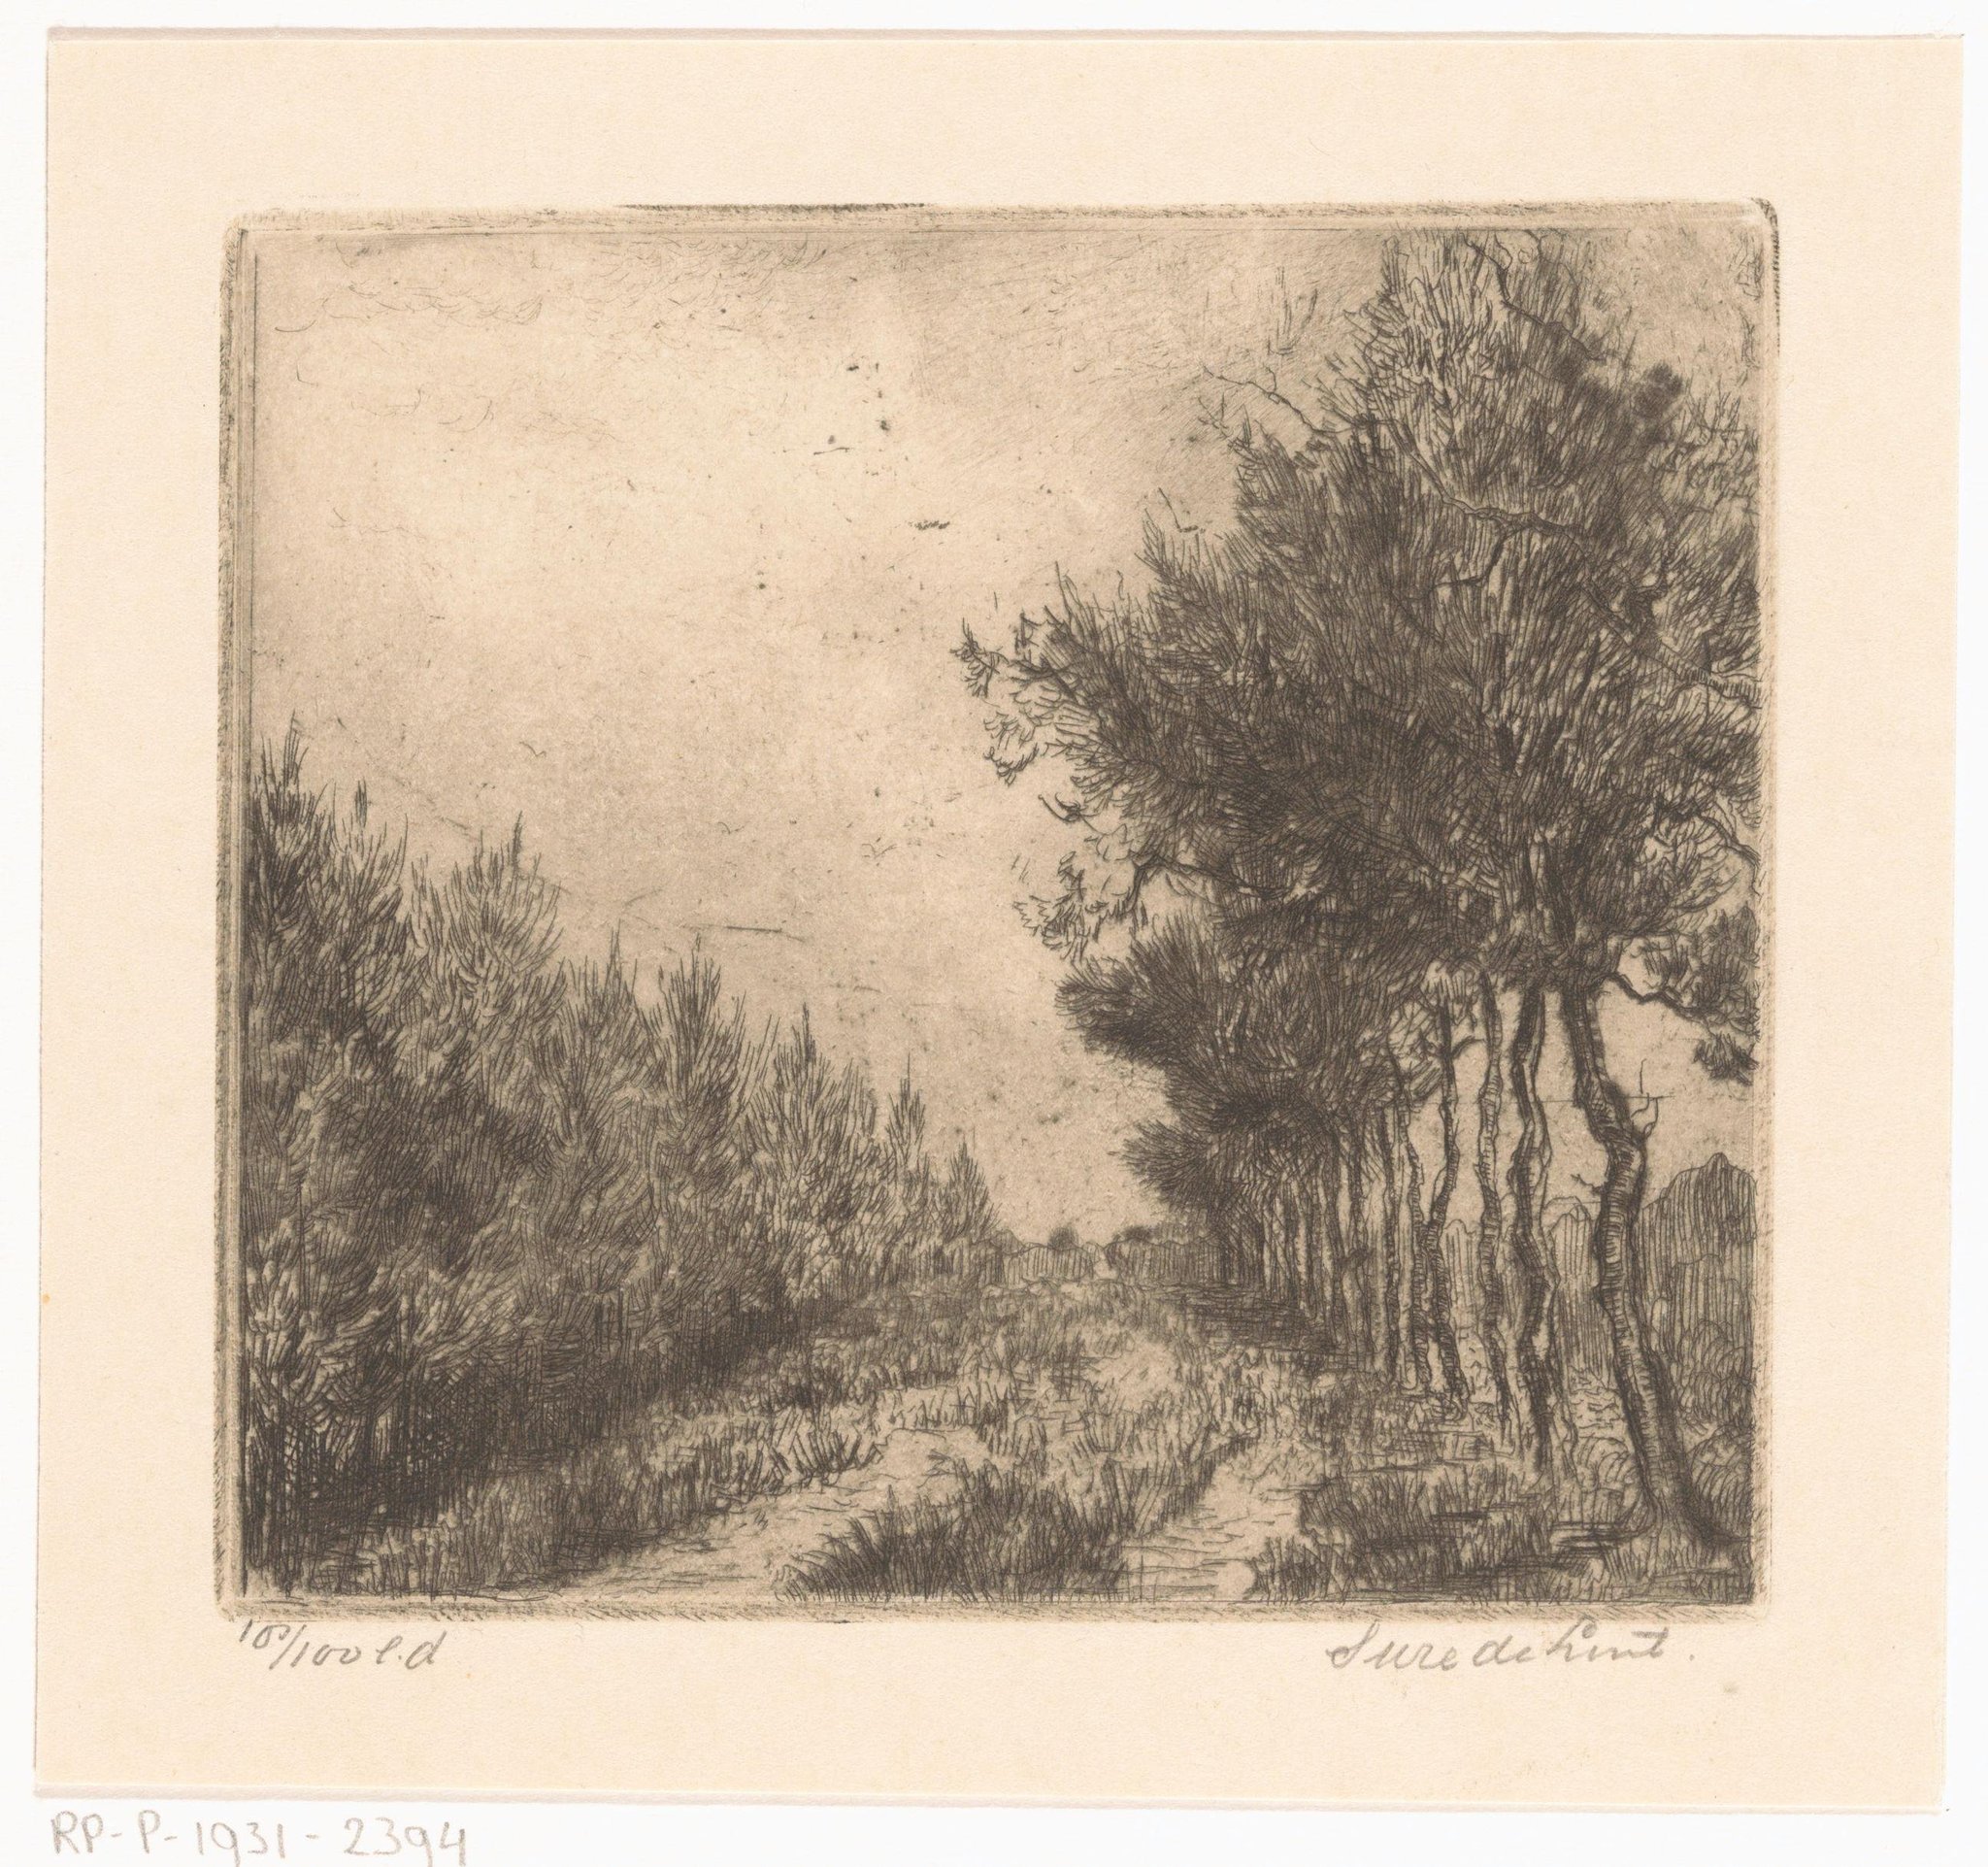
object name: print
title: Landweg met bomenrij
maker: suze de lint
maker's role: print maker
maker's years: 1878-1953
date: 1888-1931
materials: paper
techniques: etching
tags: trees, road, path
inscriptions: collector's mark: Lugt 2228